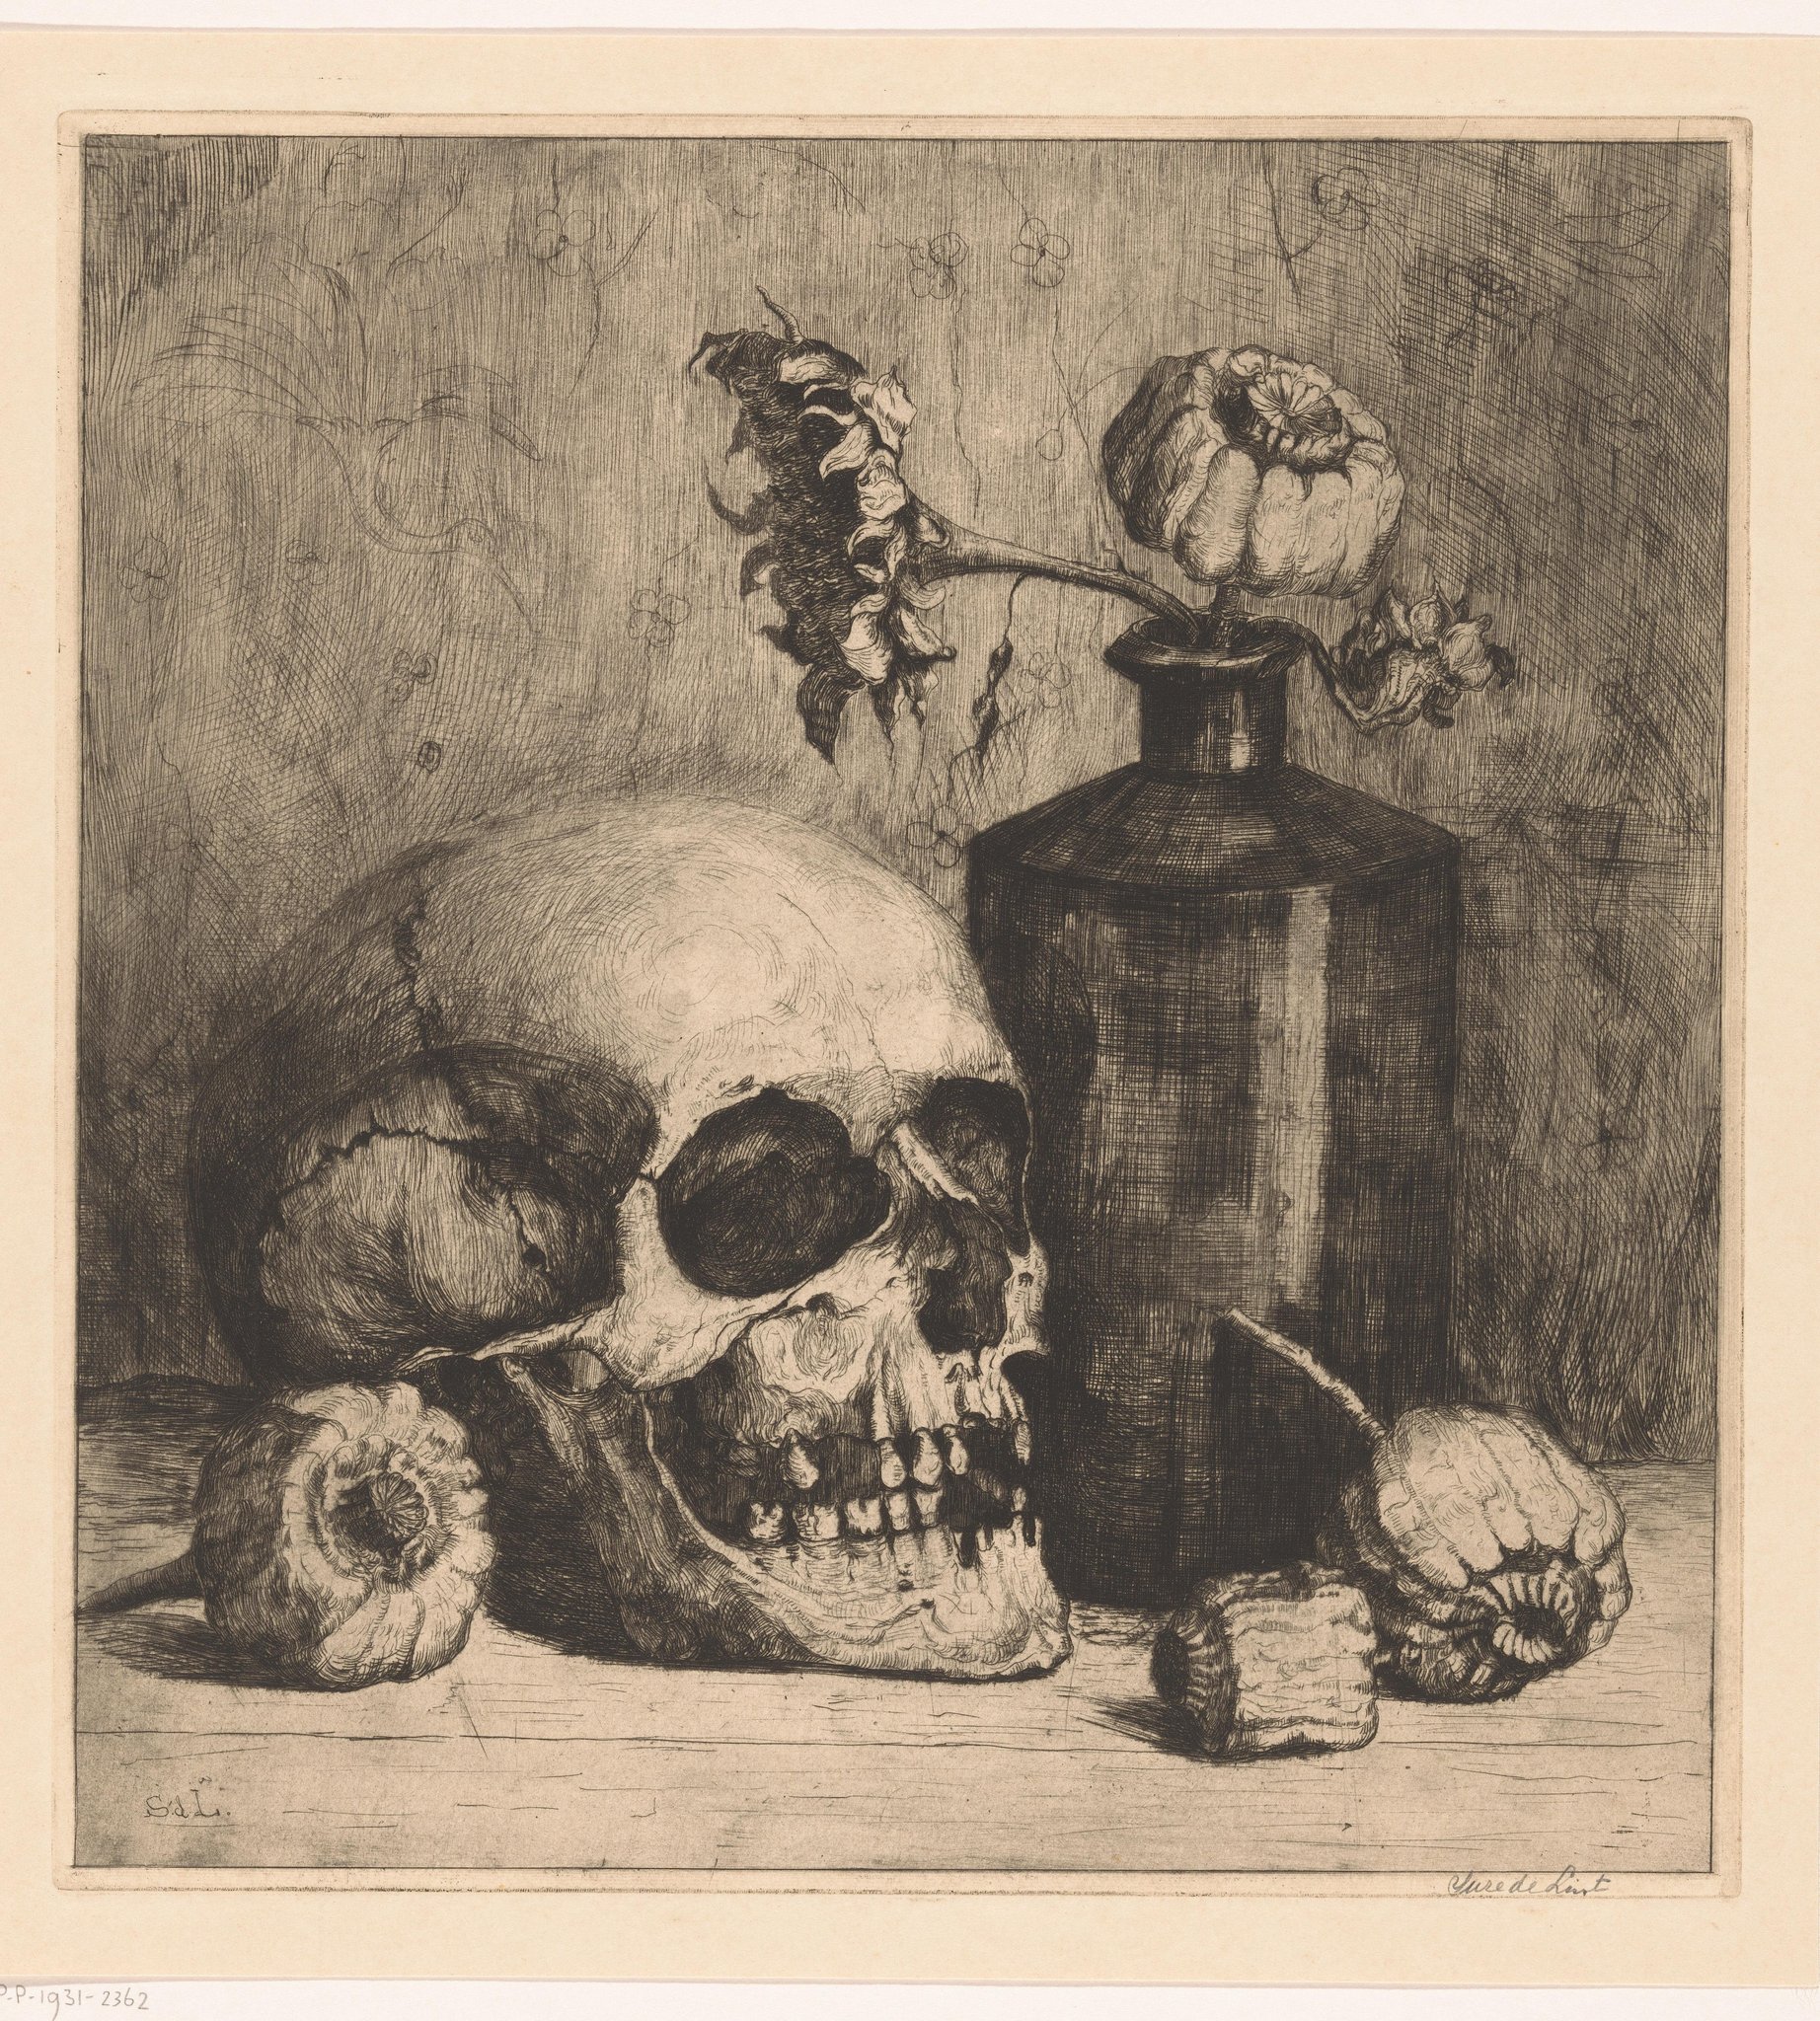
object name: print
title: Stilleven met schedel en bloemenvaas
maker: suze de lint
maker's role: print maker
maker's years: 1878-1953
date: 1888-1931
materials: paper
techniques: etching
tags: (human) skull, 'vanitas' still life, flowers in a vase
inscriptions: collector's mark: Lugt 2228